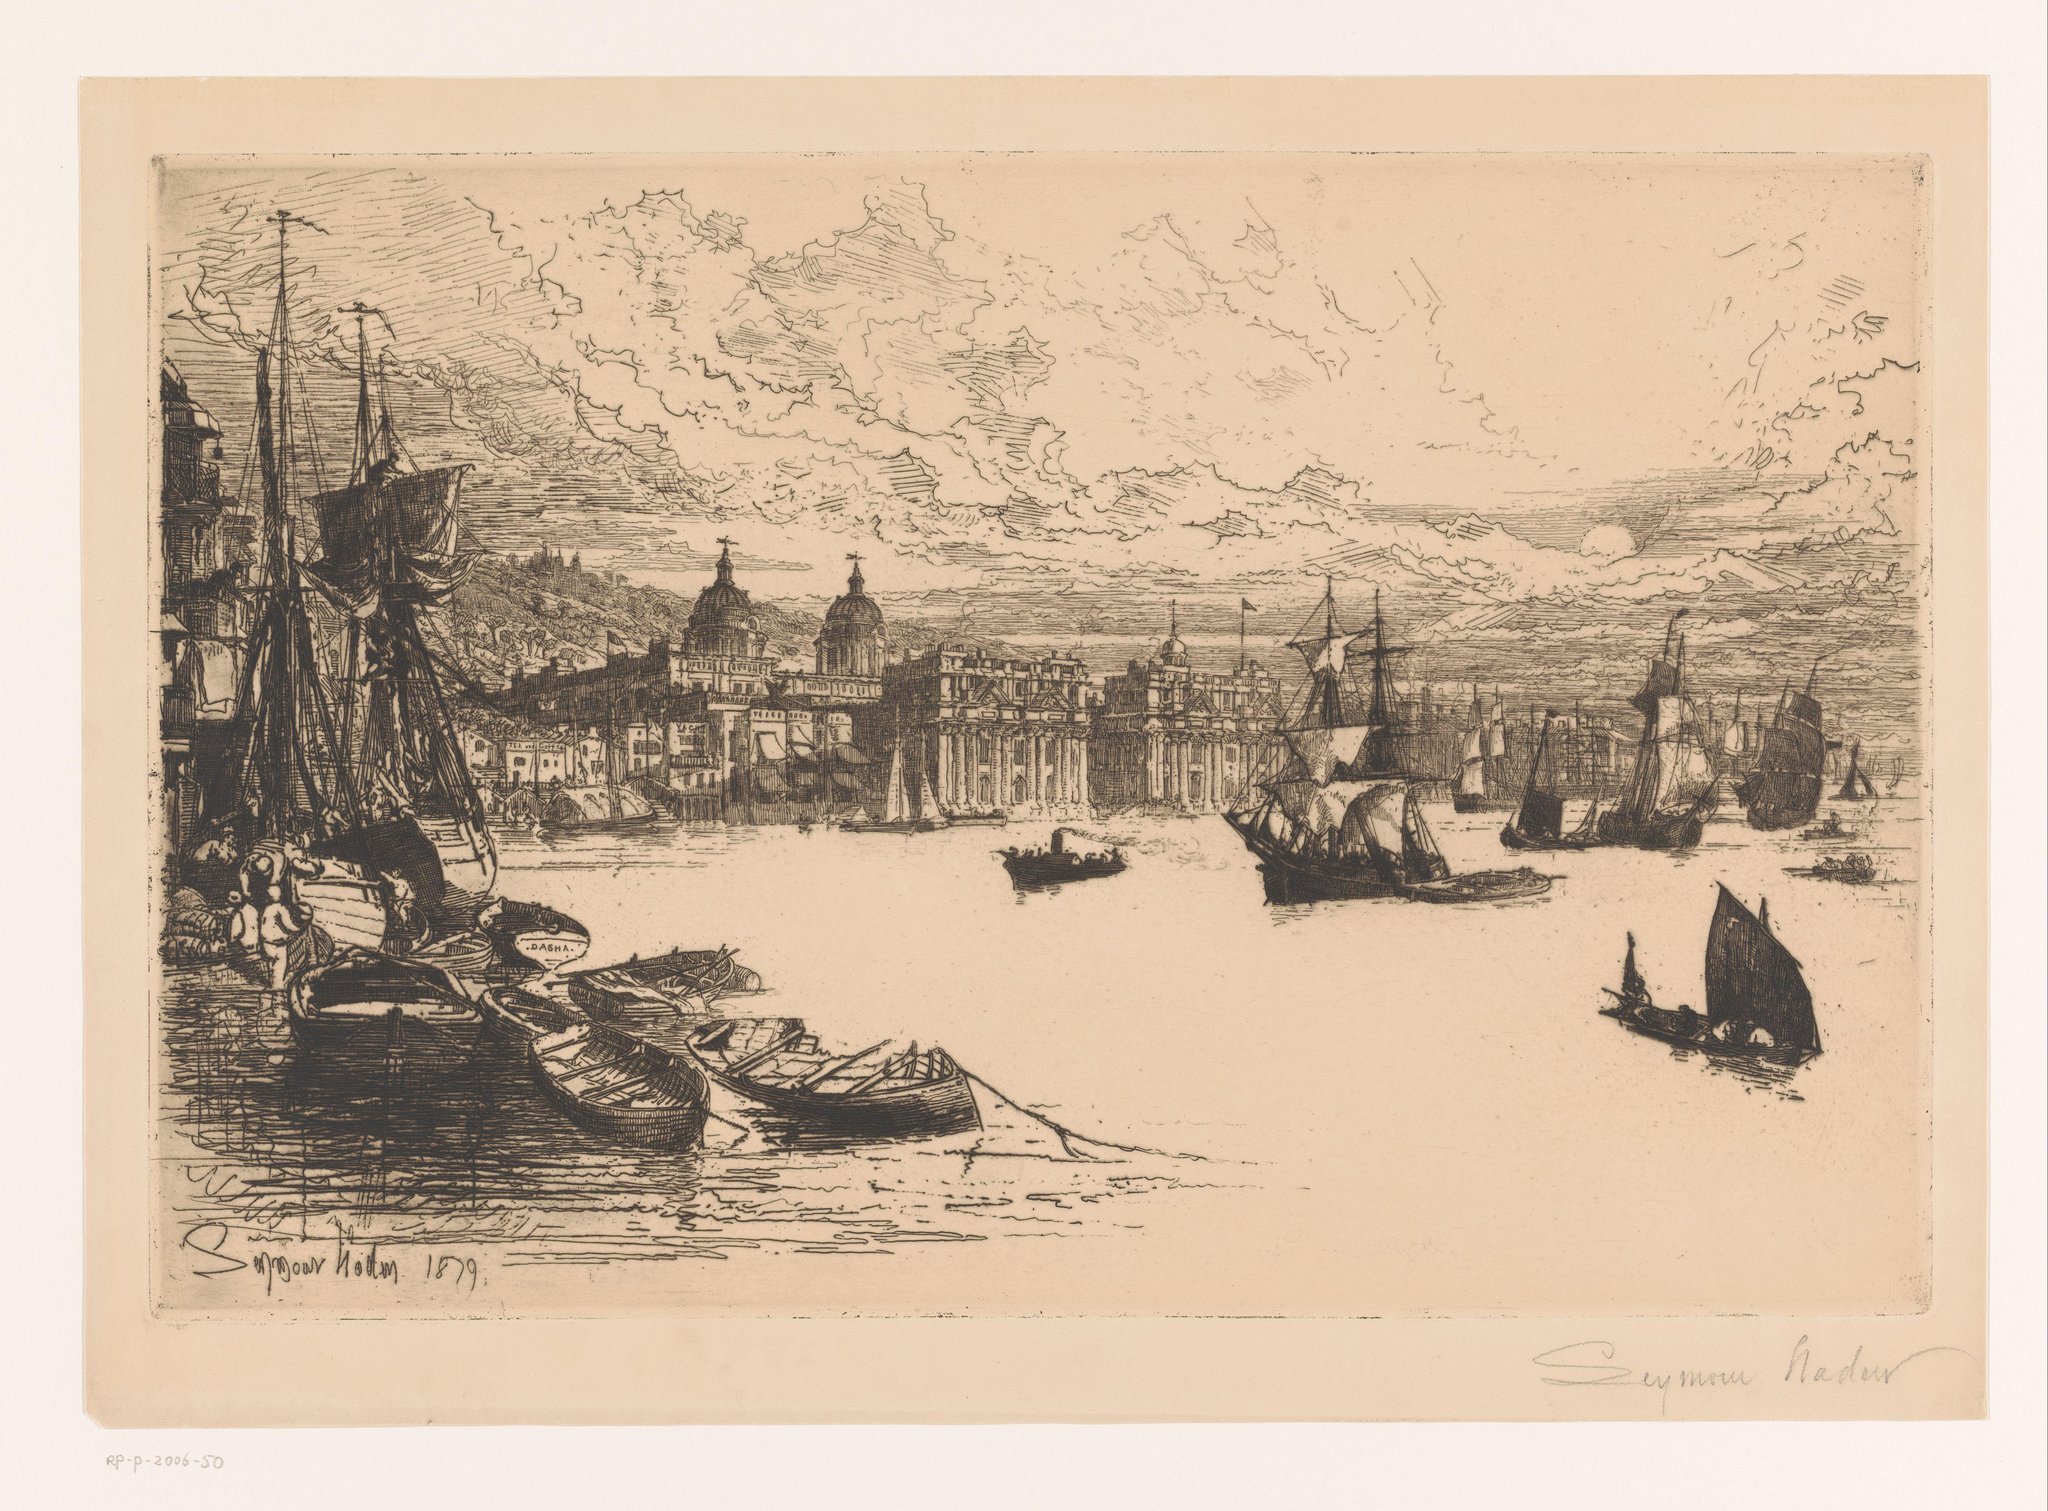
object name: print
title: Gezicht op de haven bij Greenwich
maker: francis seymour-haden (sir)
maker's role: print maker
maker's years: 1818-1910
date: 1879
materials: paper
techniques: drypoint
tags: harbour, traffic on the water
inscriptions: collector's mark: Lugt 2228, collector's mark: Lugt 2760